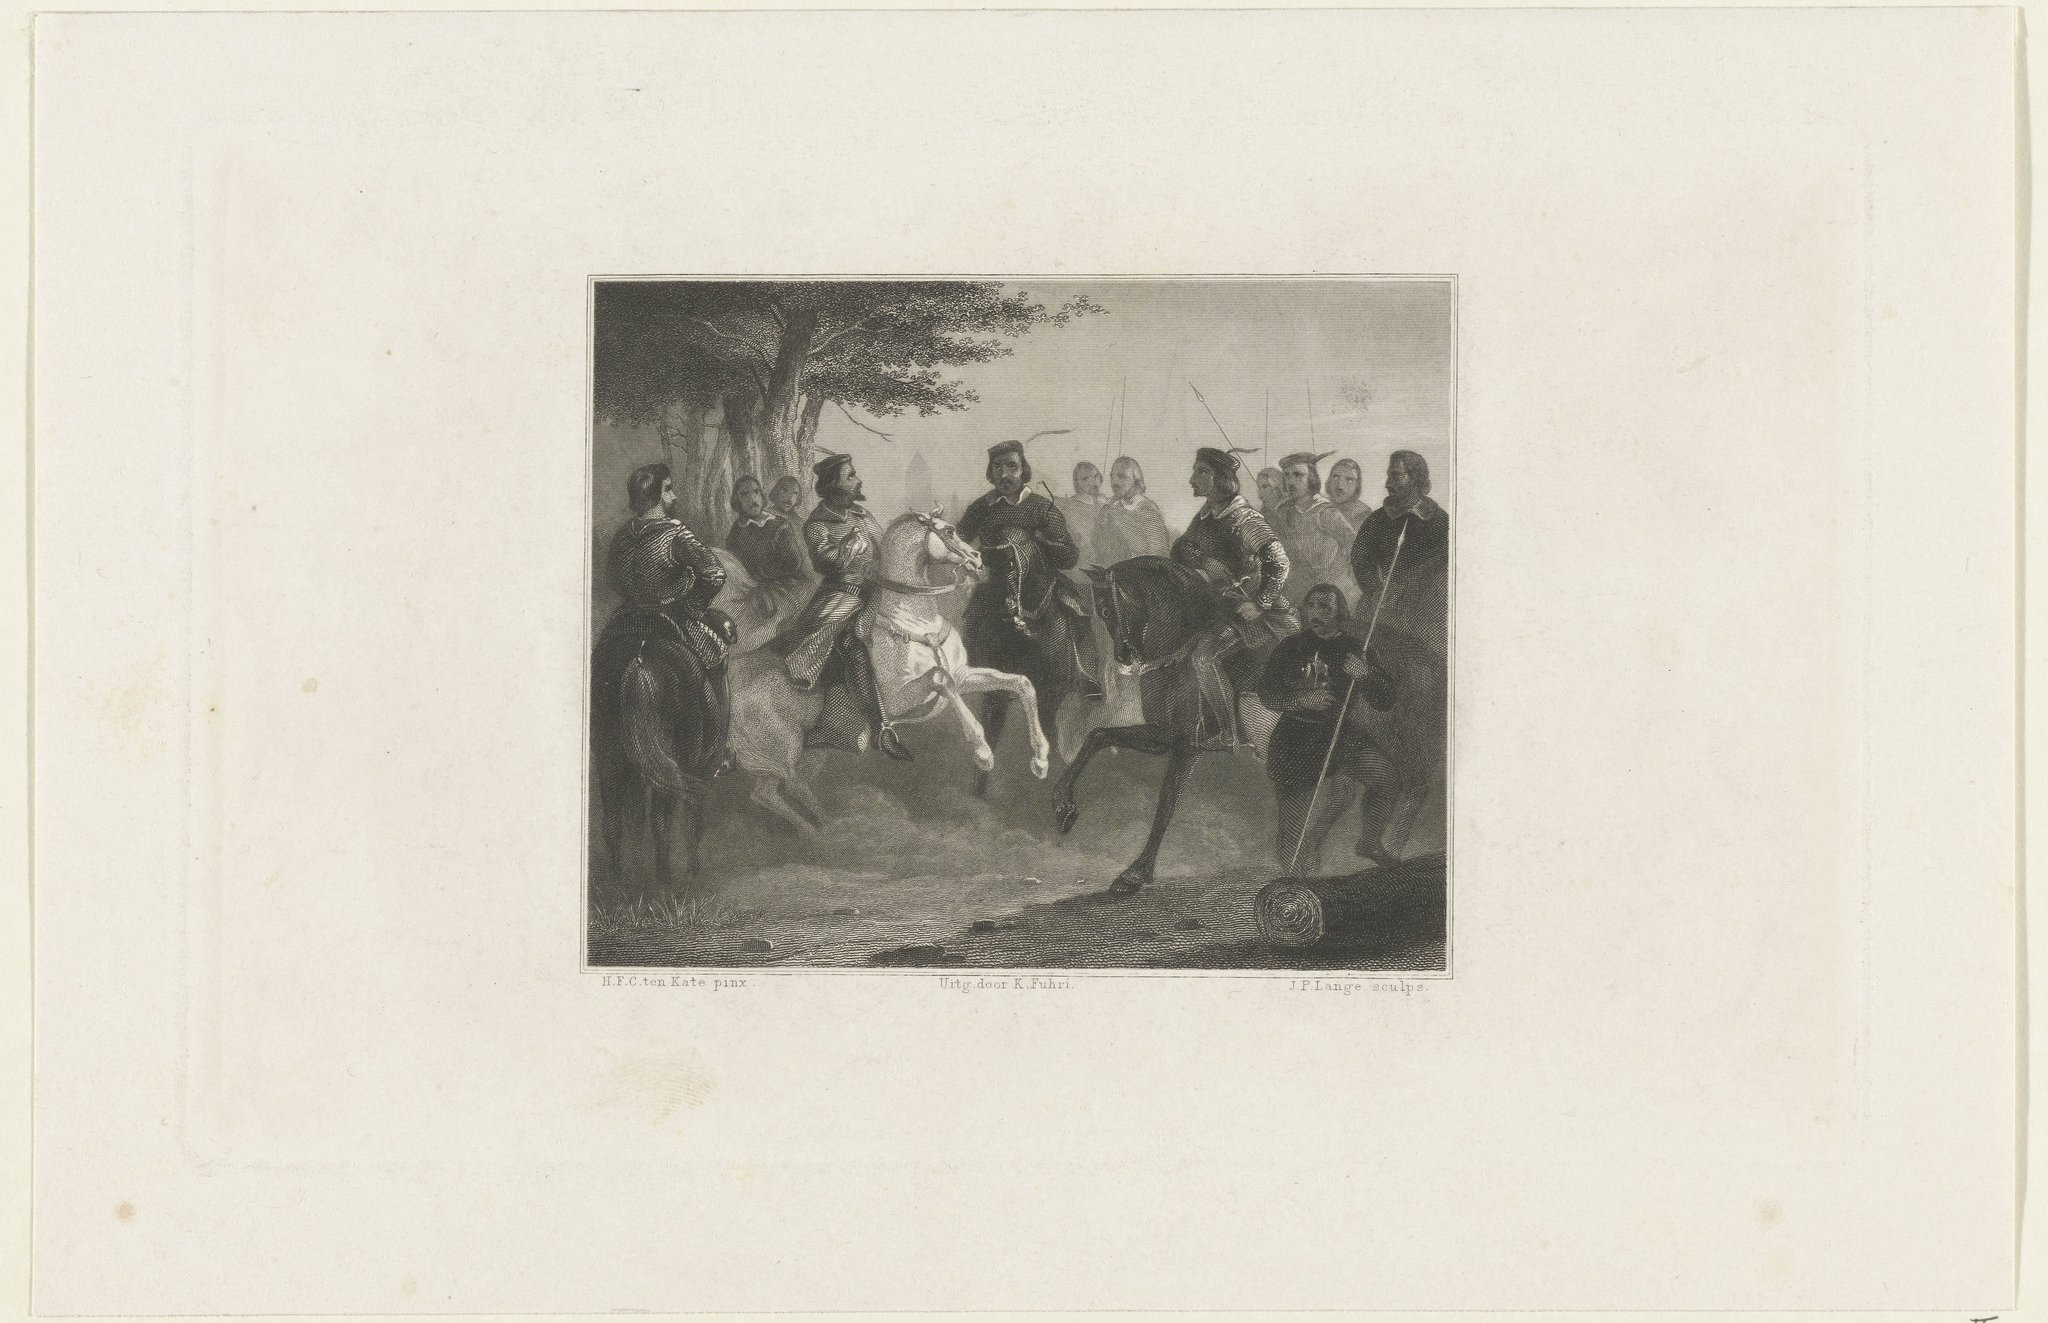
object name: history print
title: Jachtpartij van de edelen en de graaf, 1296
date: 1820-1849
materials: paper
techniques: engraving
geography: netherlands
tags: floris v (graaf van holland en zeeland), hunting, chase, netherlands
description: Jachtpartij van de edelen en de graaf Floris V. Landschap met edelen te paard.